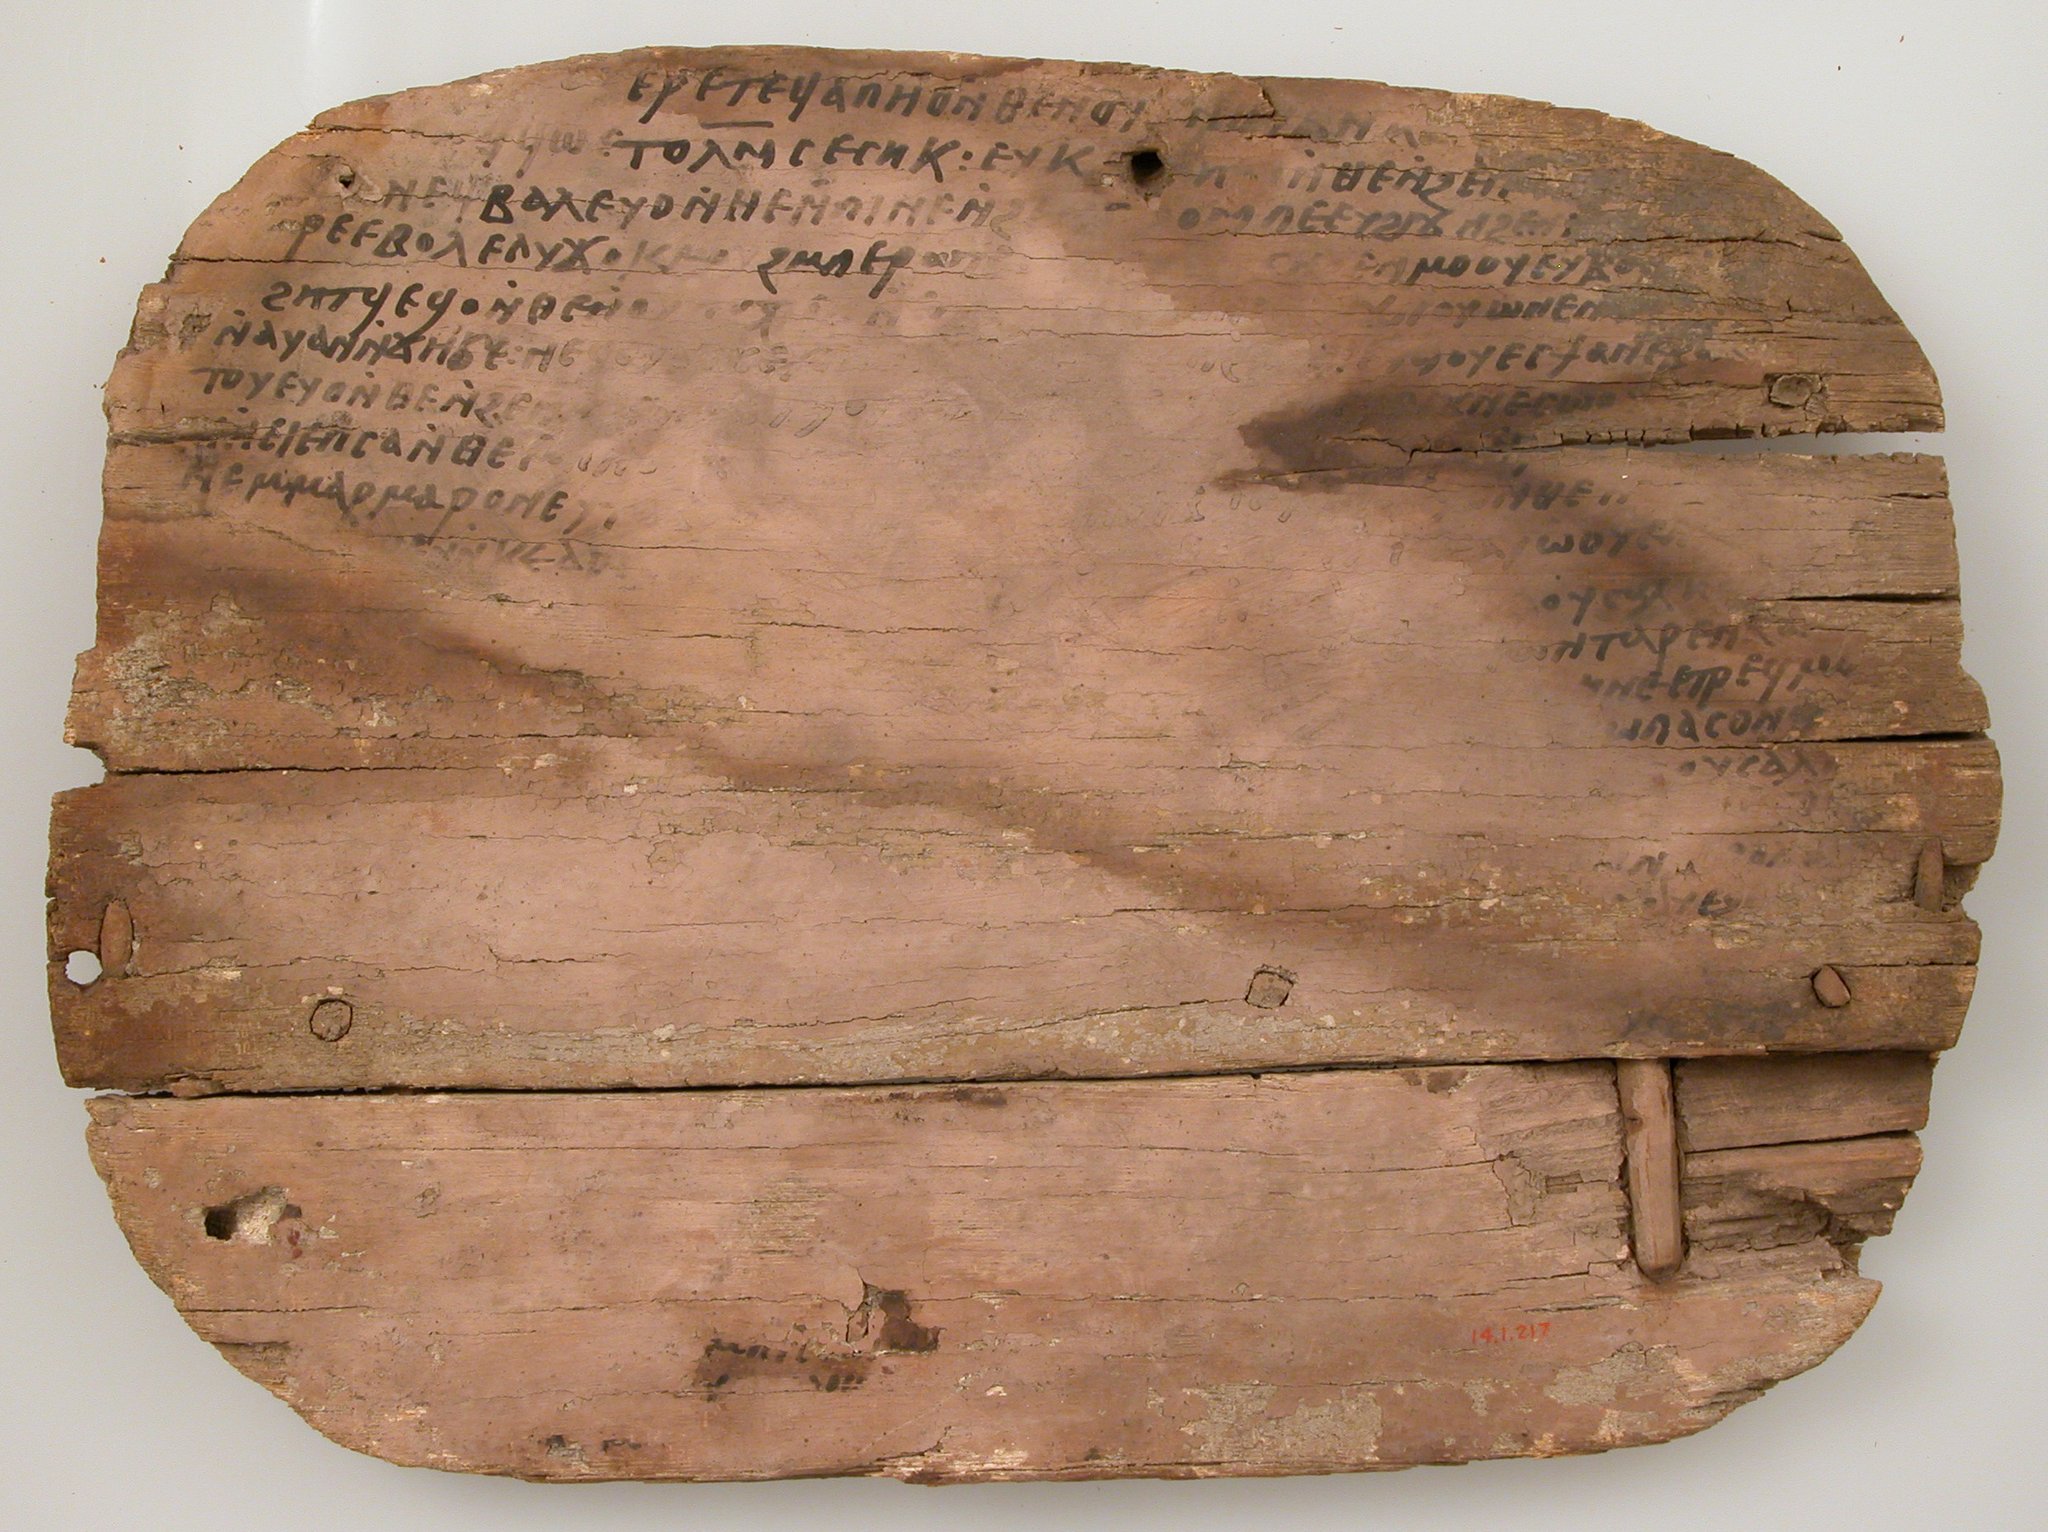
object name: ostrakon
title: Ostrakon with Text from Song of Songs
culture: coptic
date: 580-640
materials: ink, wood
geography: egypt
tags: coptic,documents